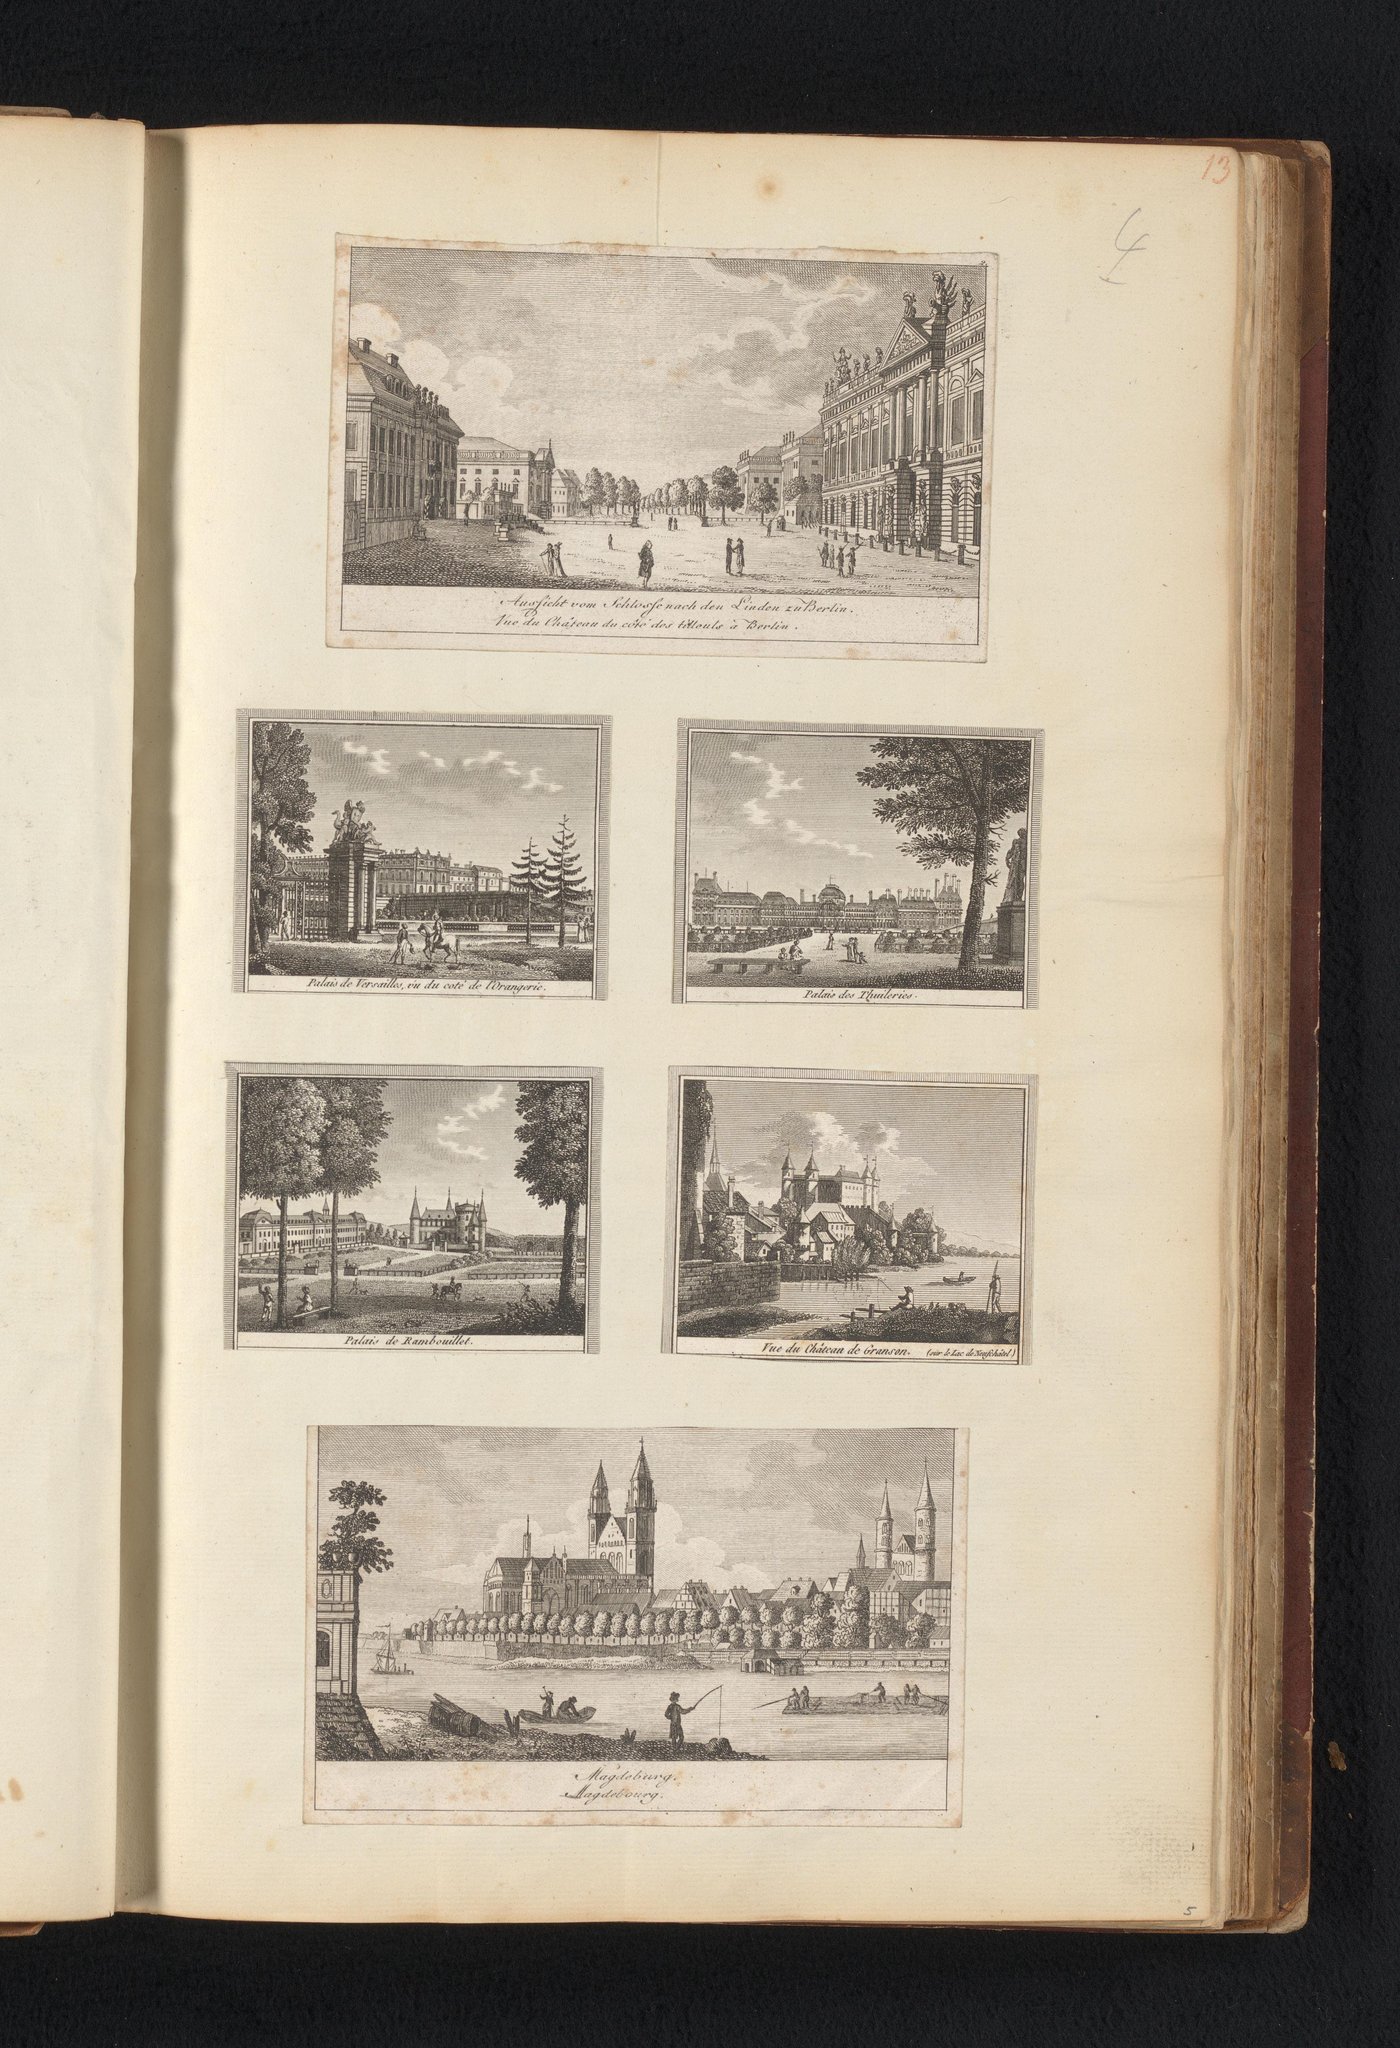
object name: print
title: Gezichten te Parijs, Berlijn en Maagdenburg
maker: Anonymous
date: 1750-1816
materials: paper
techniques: engraving, etching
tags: city-view in general; 'veduta', church (exterior), paris, berlin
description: Vier gezichten te Parijs, en twee te Berlijn en Maagdenburg. Onderdeel van het tweede van twee albums met ingeplakte prenten en tekeningen te dienen als tekenvoorbeelden.